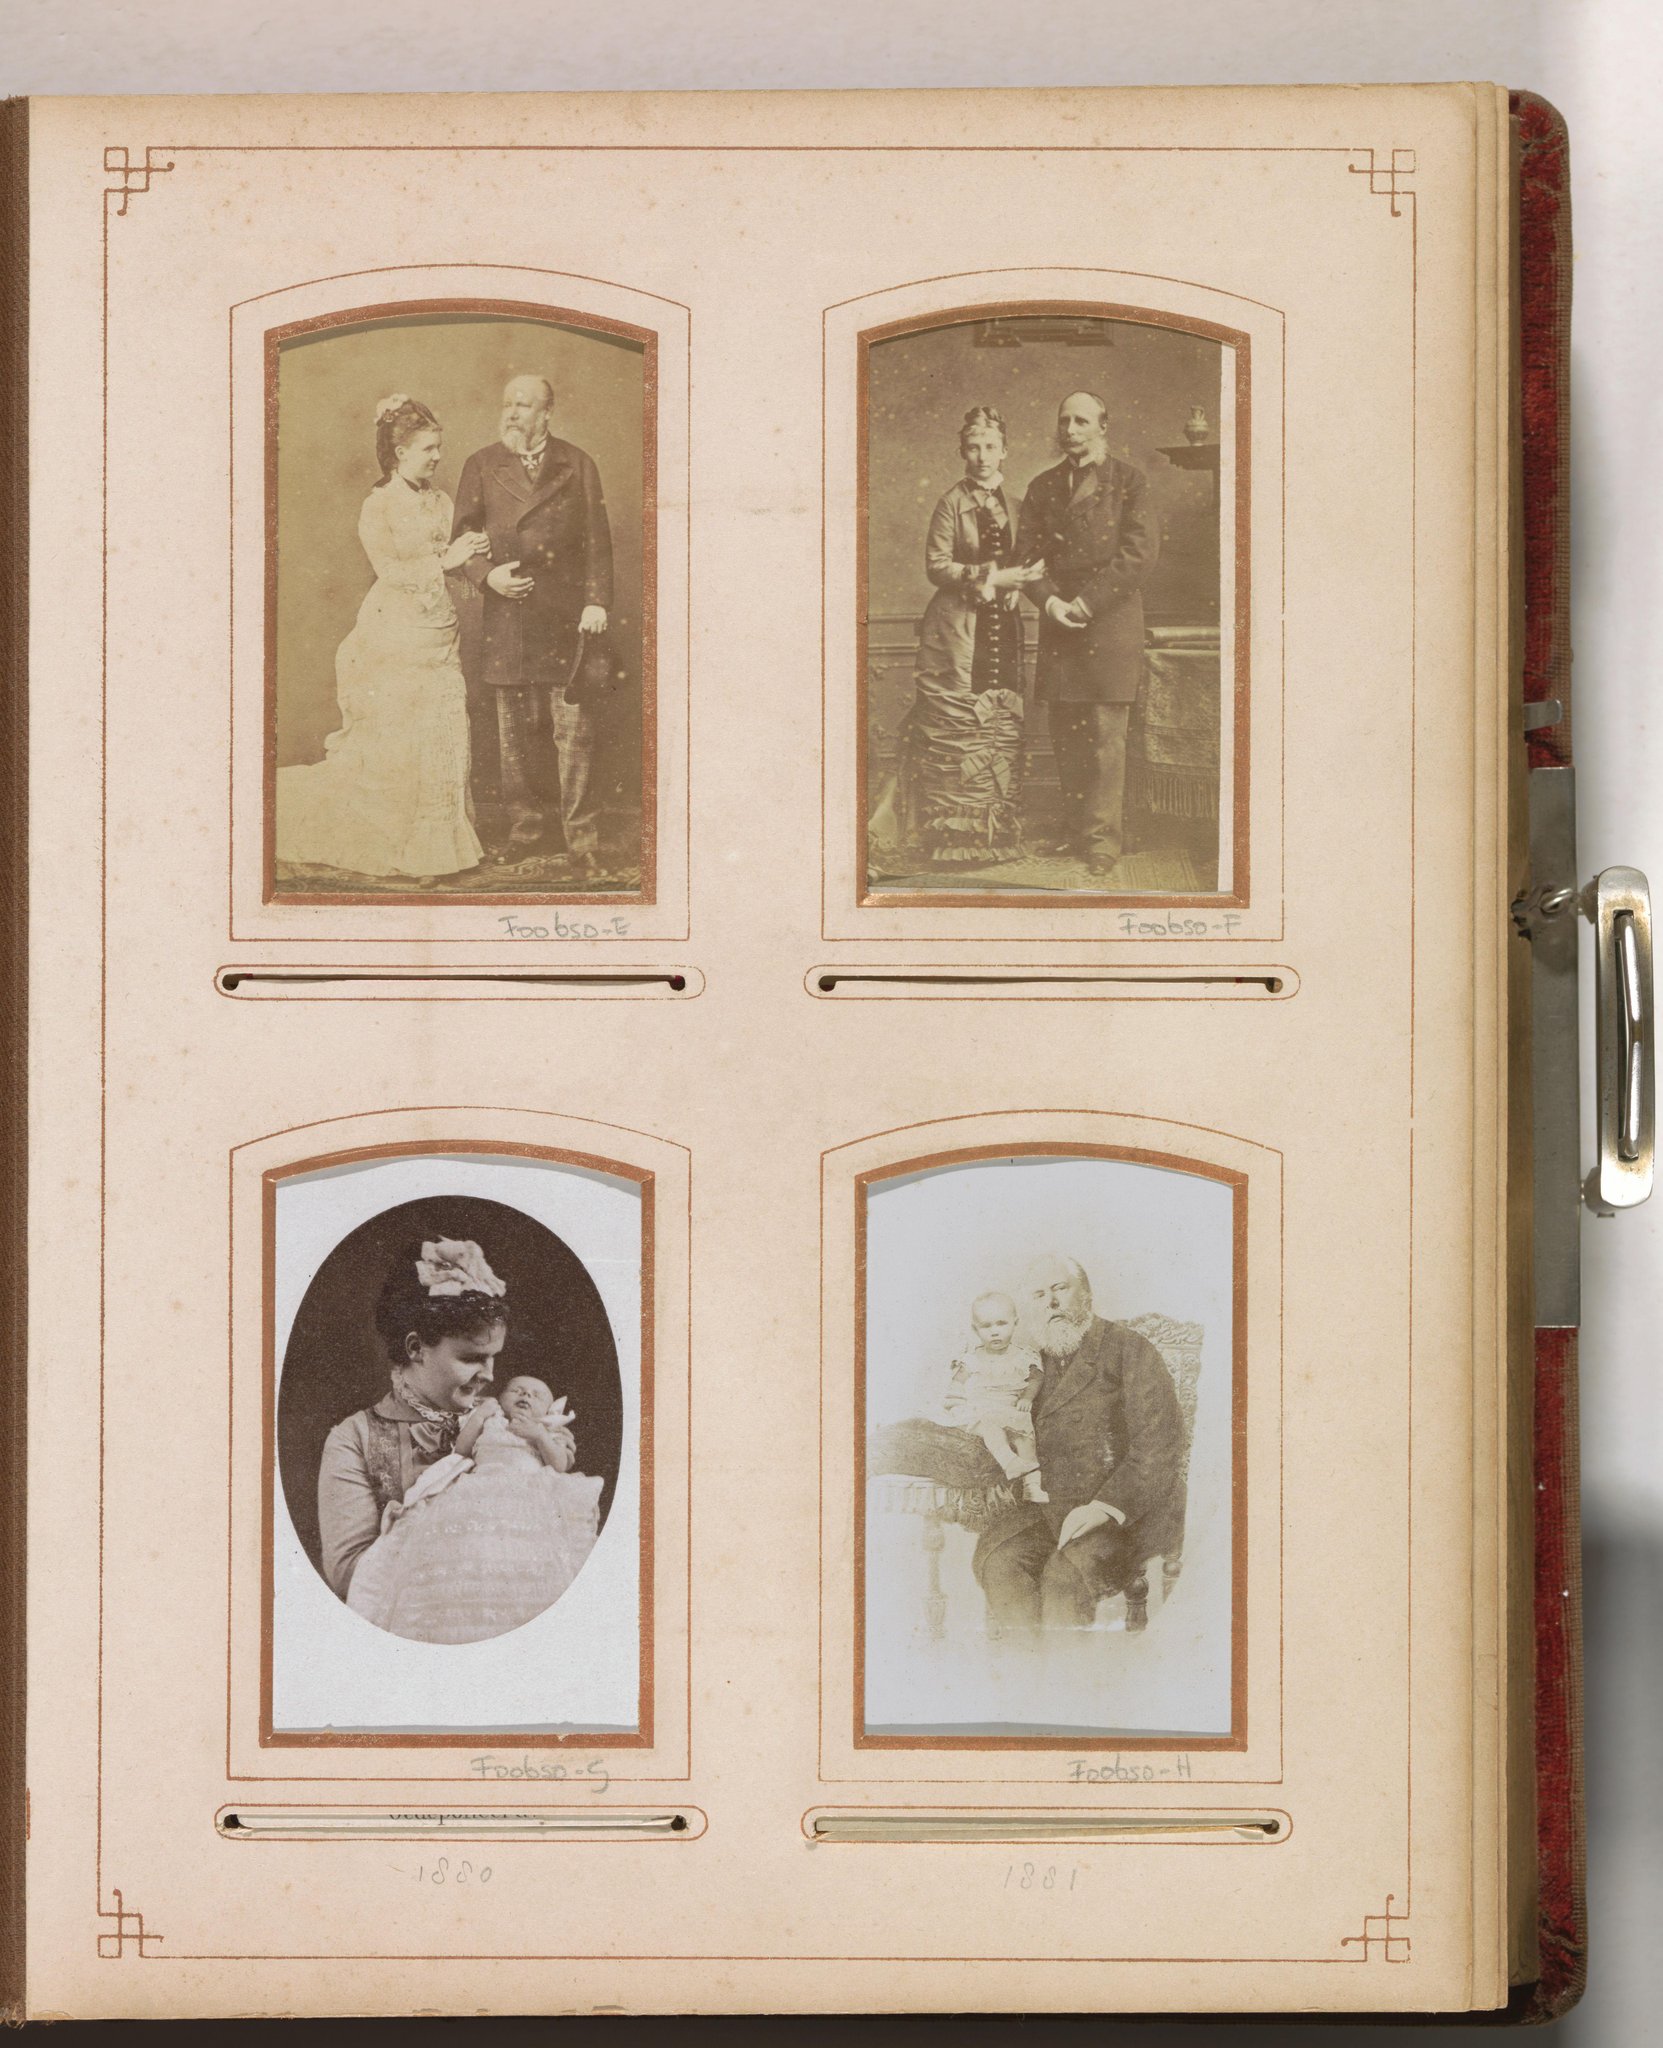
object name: album leaf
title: Portret van koning Willem III met prinses Wilhelmina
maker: Anonymous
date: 1881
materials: cardboard, paper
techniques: autotype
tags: the hague, print maker, wilhelmina of the netherlands, brussels, willem iii (koning der nederlanden), father and daughter(s) (family group), historical persons, king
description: Deze fotomechanische afdruk maakt deel uit van een album.